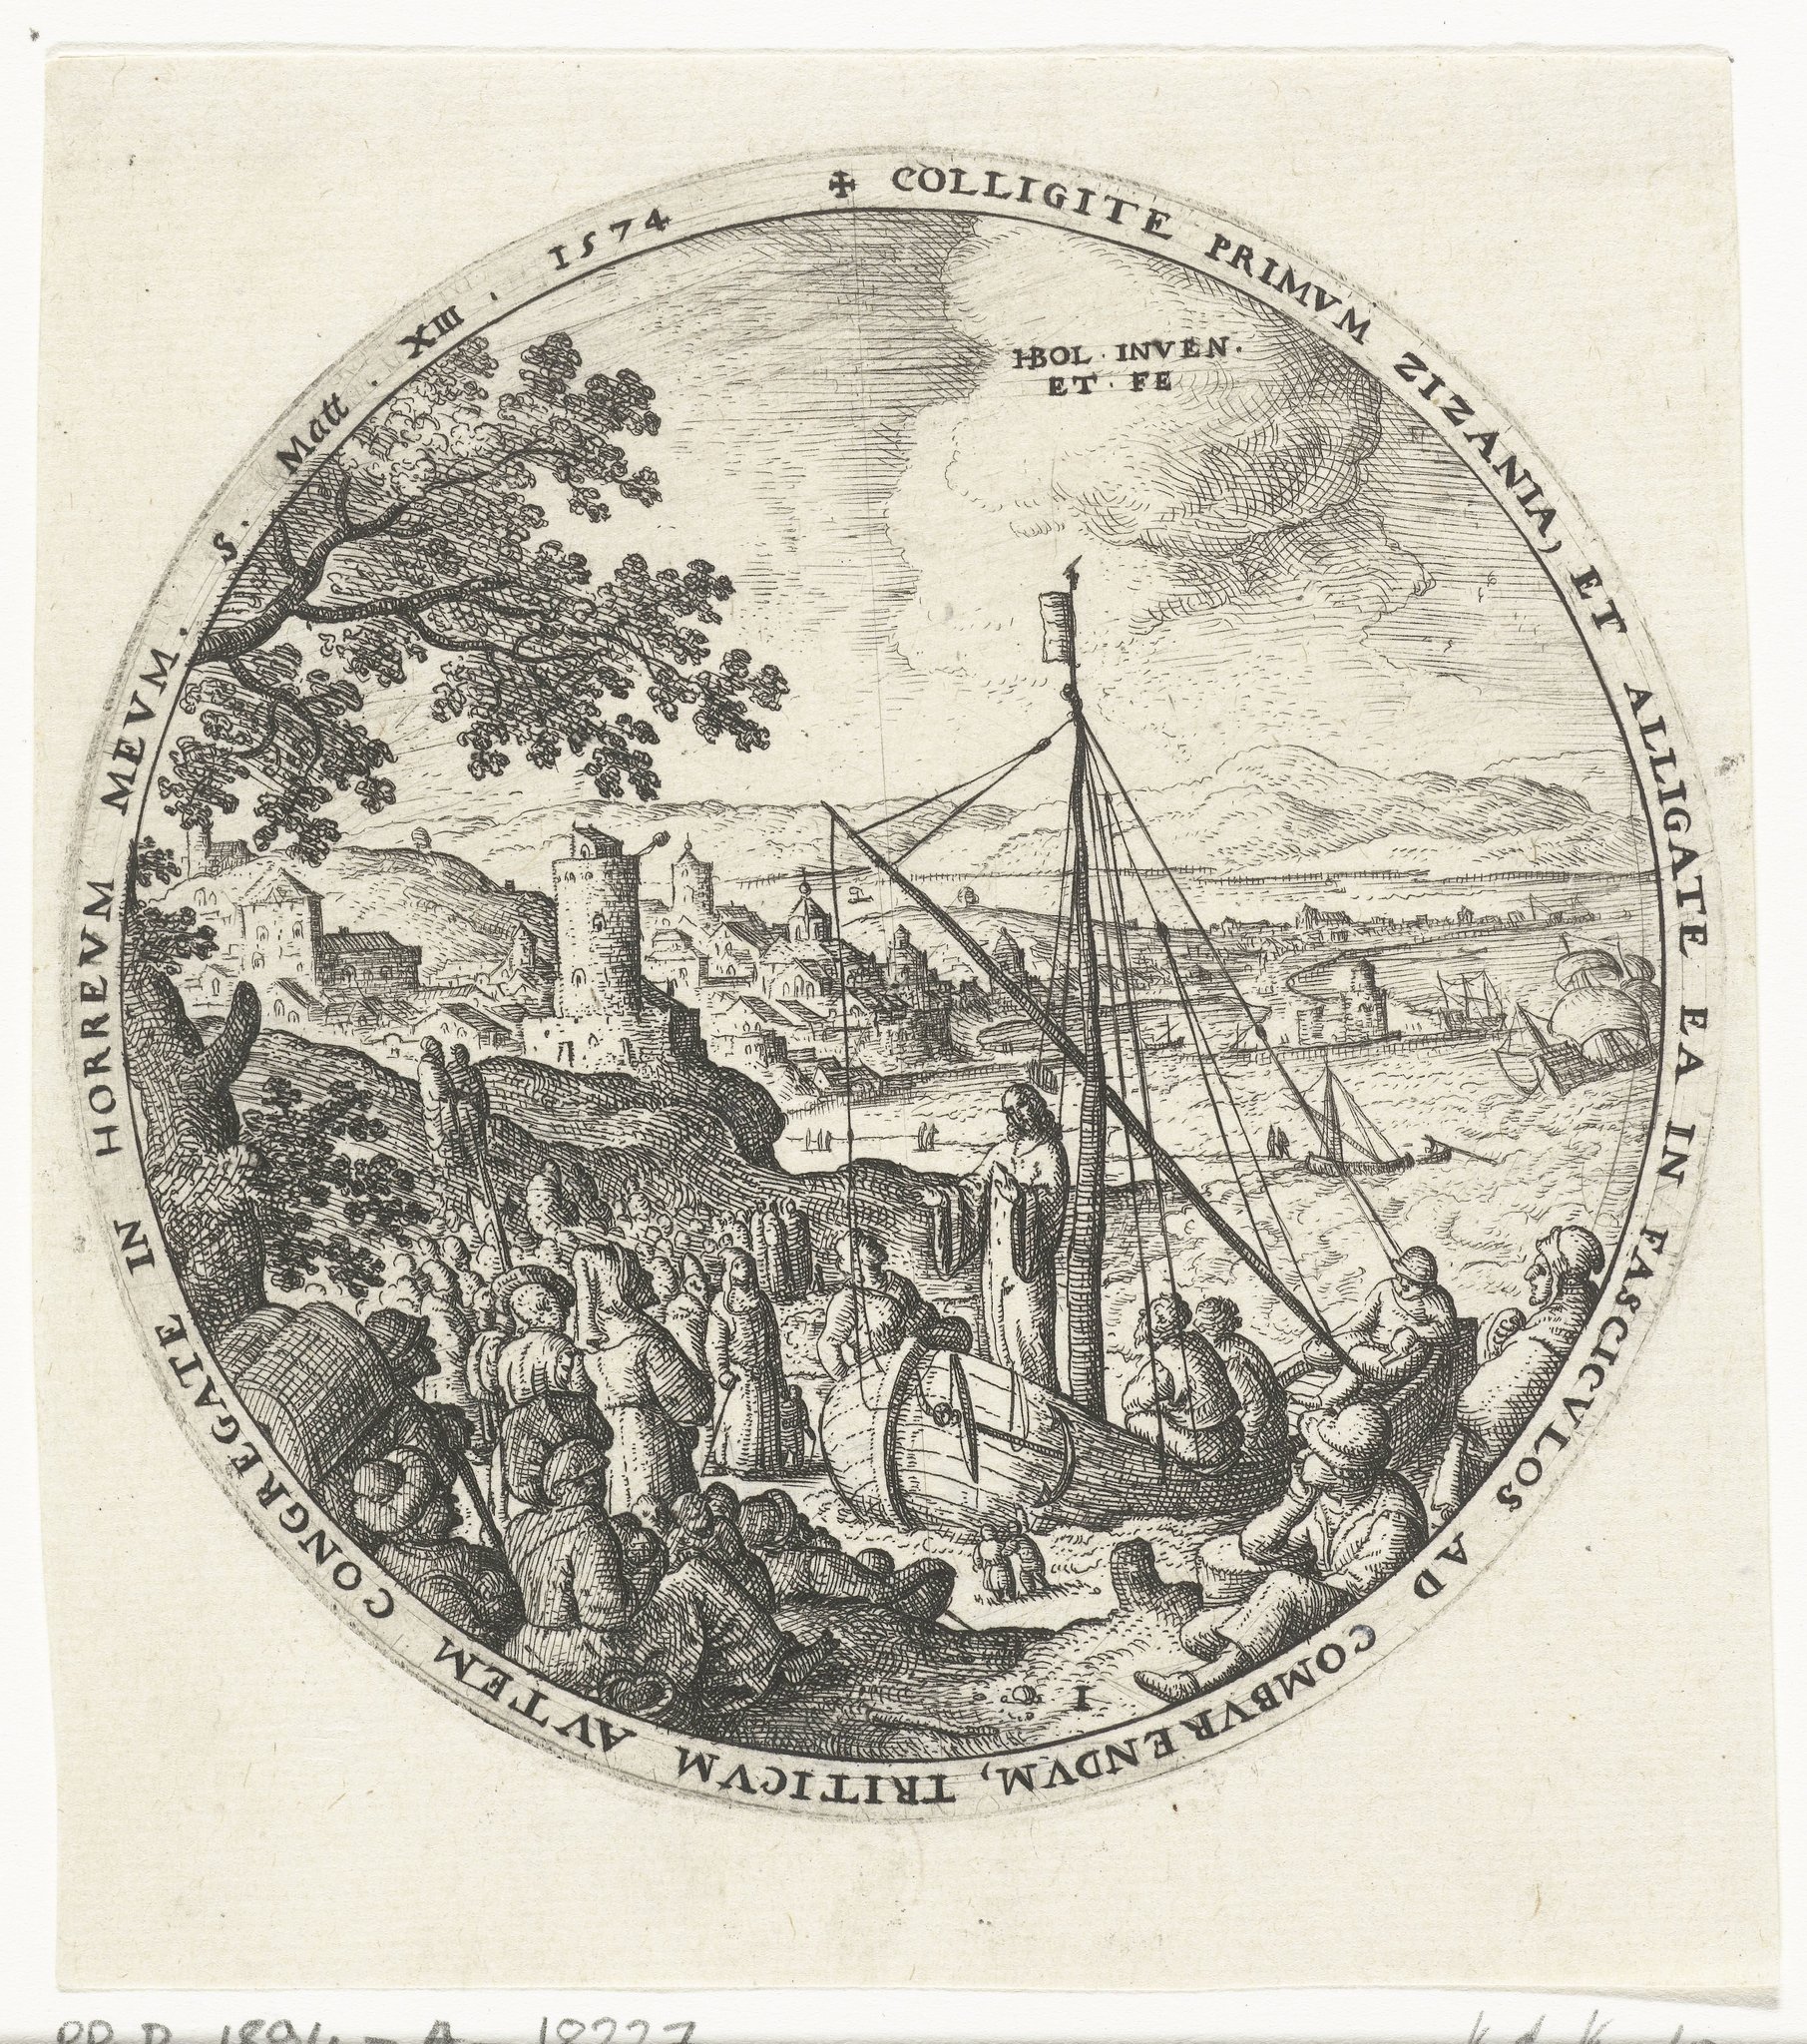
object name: print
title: Christus preekt aan de oever van het meer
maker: hans bol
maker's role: draughtsman, print maker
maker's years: 1534-1593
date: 1574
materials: paper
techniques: etching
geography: southern netherlands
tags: christ preaching from a boat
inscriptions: date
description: Christus gaat bij de oever van het meer in een boot staan en preekt voor de mensen. Met een Latijns randschrift.